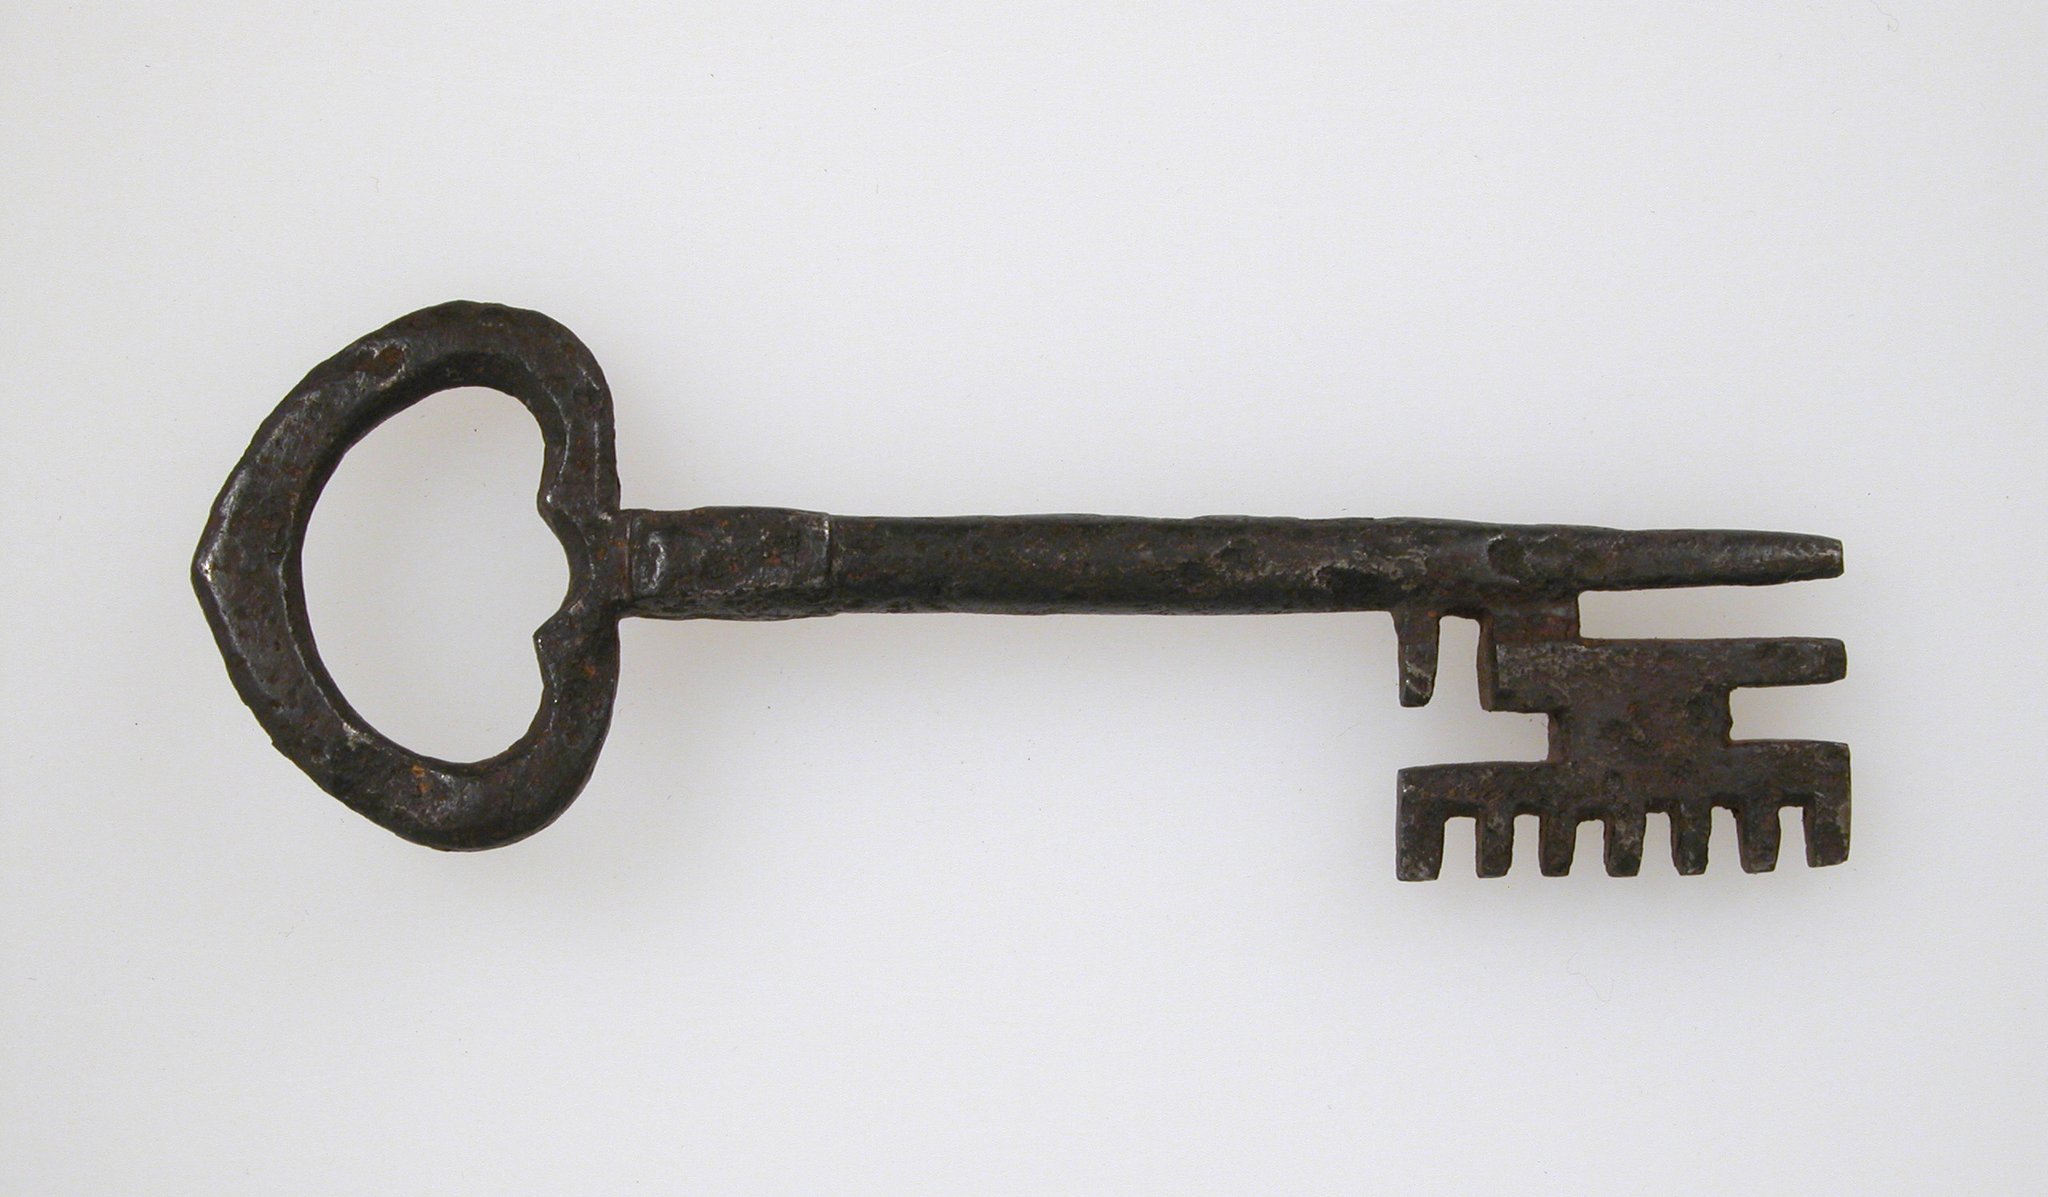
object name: key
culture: german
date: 1301-1400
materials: iron